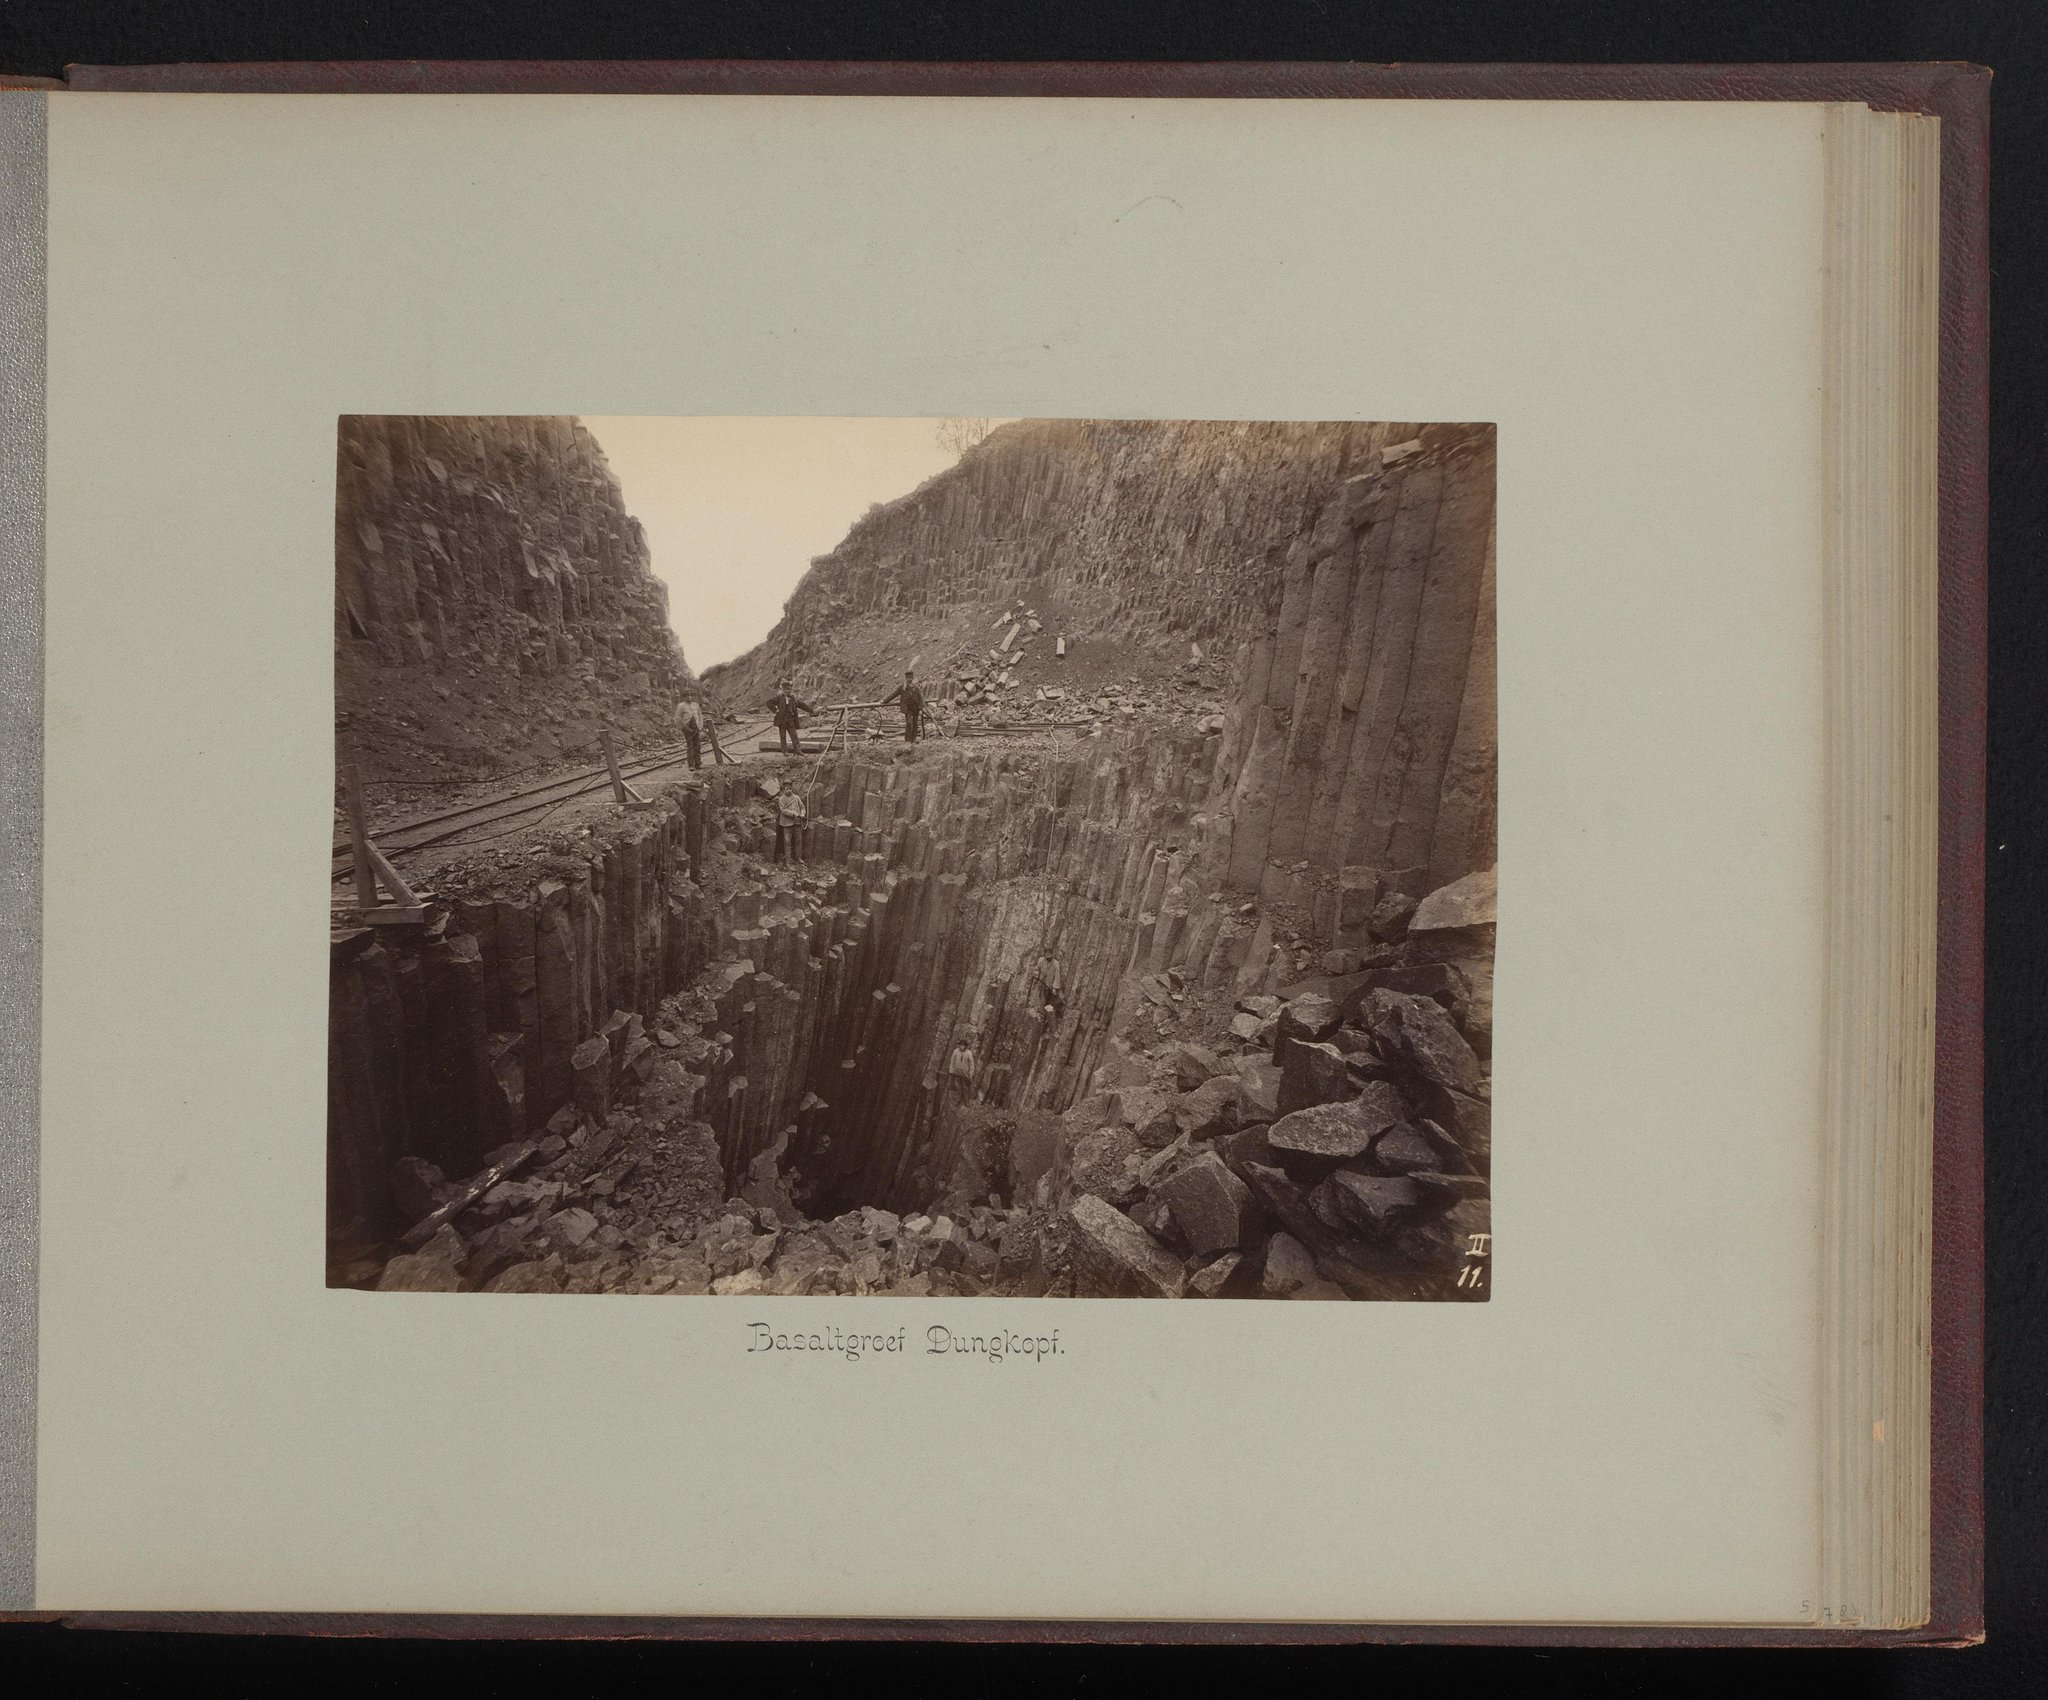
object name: album leaf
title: Gezicht op de basaltgroeve Dungkopf in Remagen, Duitsland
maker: Anonymous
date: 1883-1900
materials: cardboard, photographic support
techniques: albumen print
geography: remagen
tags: quarry (+ stone), railway, train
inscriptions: number: ‘II/ 11.’